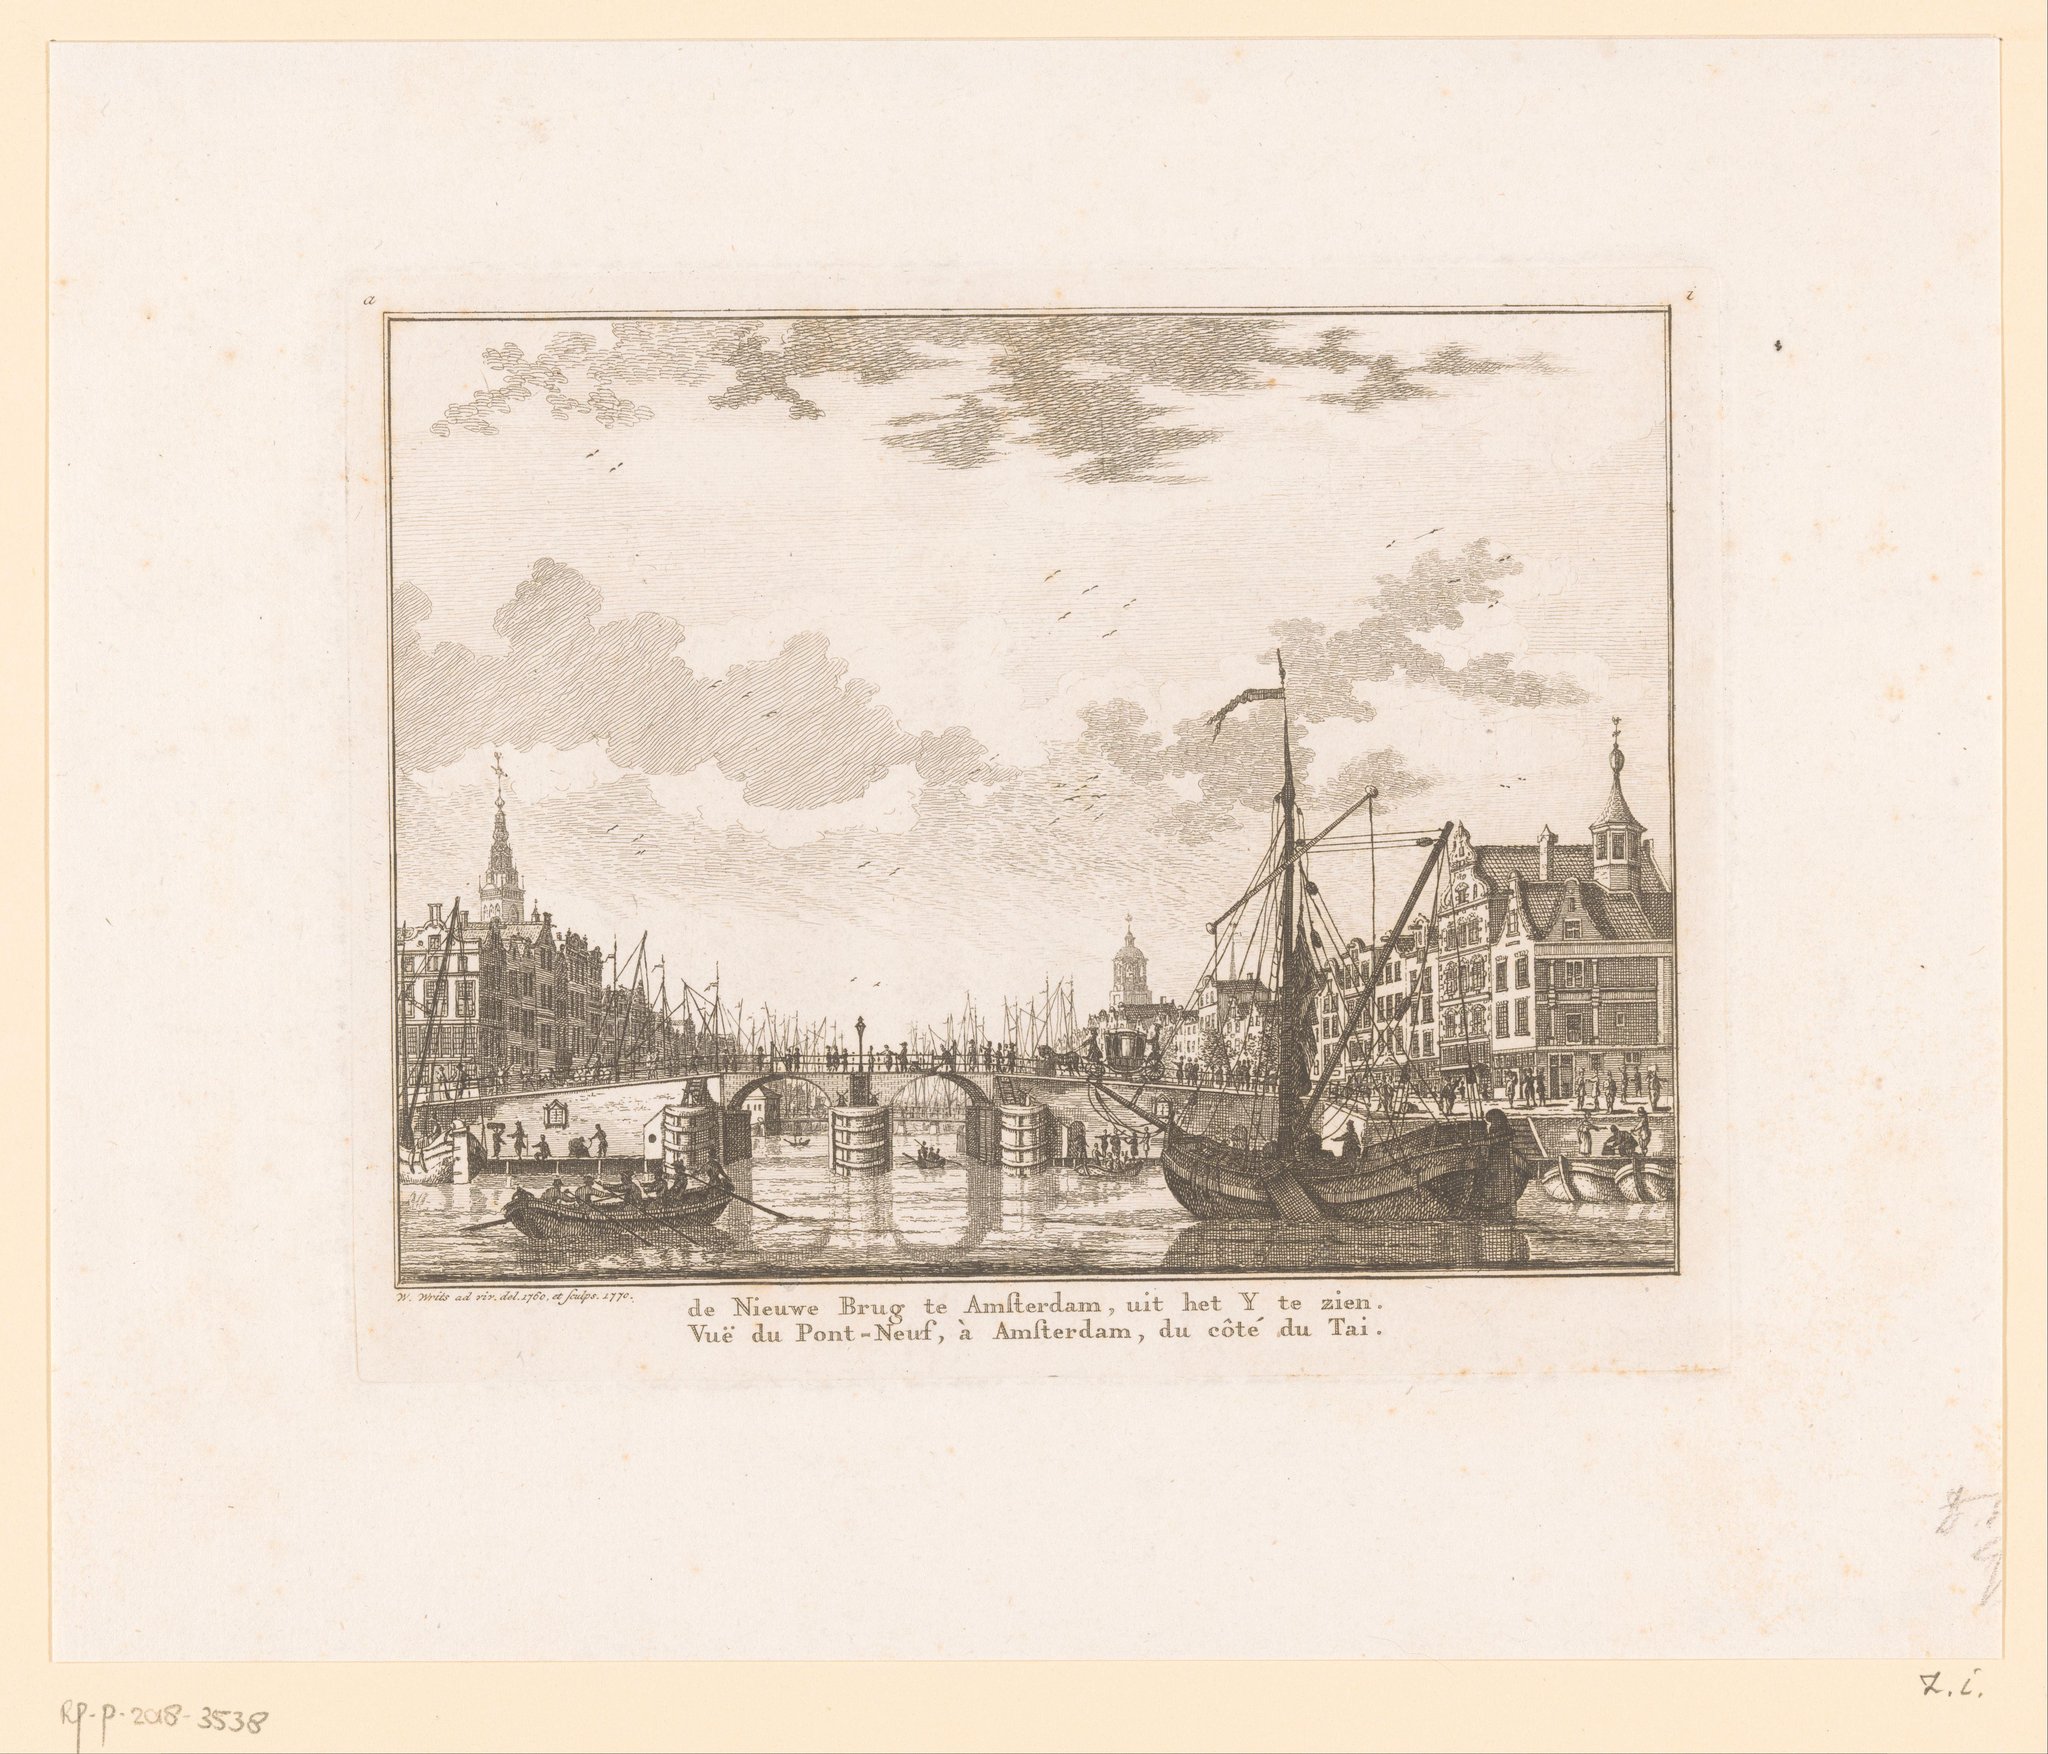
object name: book illustration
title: Gezicht op de Nieuwe Brug en het Damrak in Amsterdam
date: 1804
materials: paper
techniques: etching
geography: amsterdam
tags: sailing-ship, sailing-boat, rowing-boat, canoe, etc., bridge in city across river, canal, etc., prospect of city, town panorama, silhouette of city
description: Prent uit: Elwe, Jan Barend. Atlas van de wereldberoemde koopstad Amsteldam (...). Amsterdam: Jan Barend Elwe, 1804.